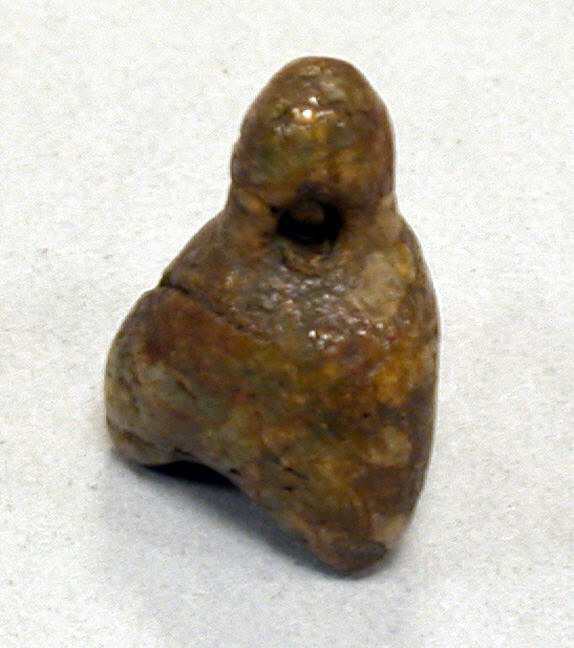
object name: pendant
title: Stone Figure (?) Pendant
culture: costa rican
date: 801-1500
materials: stone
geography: costa rica